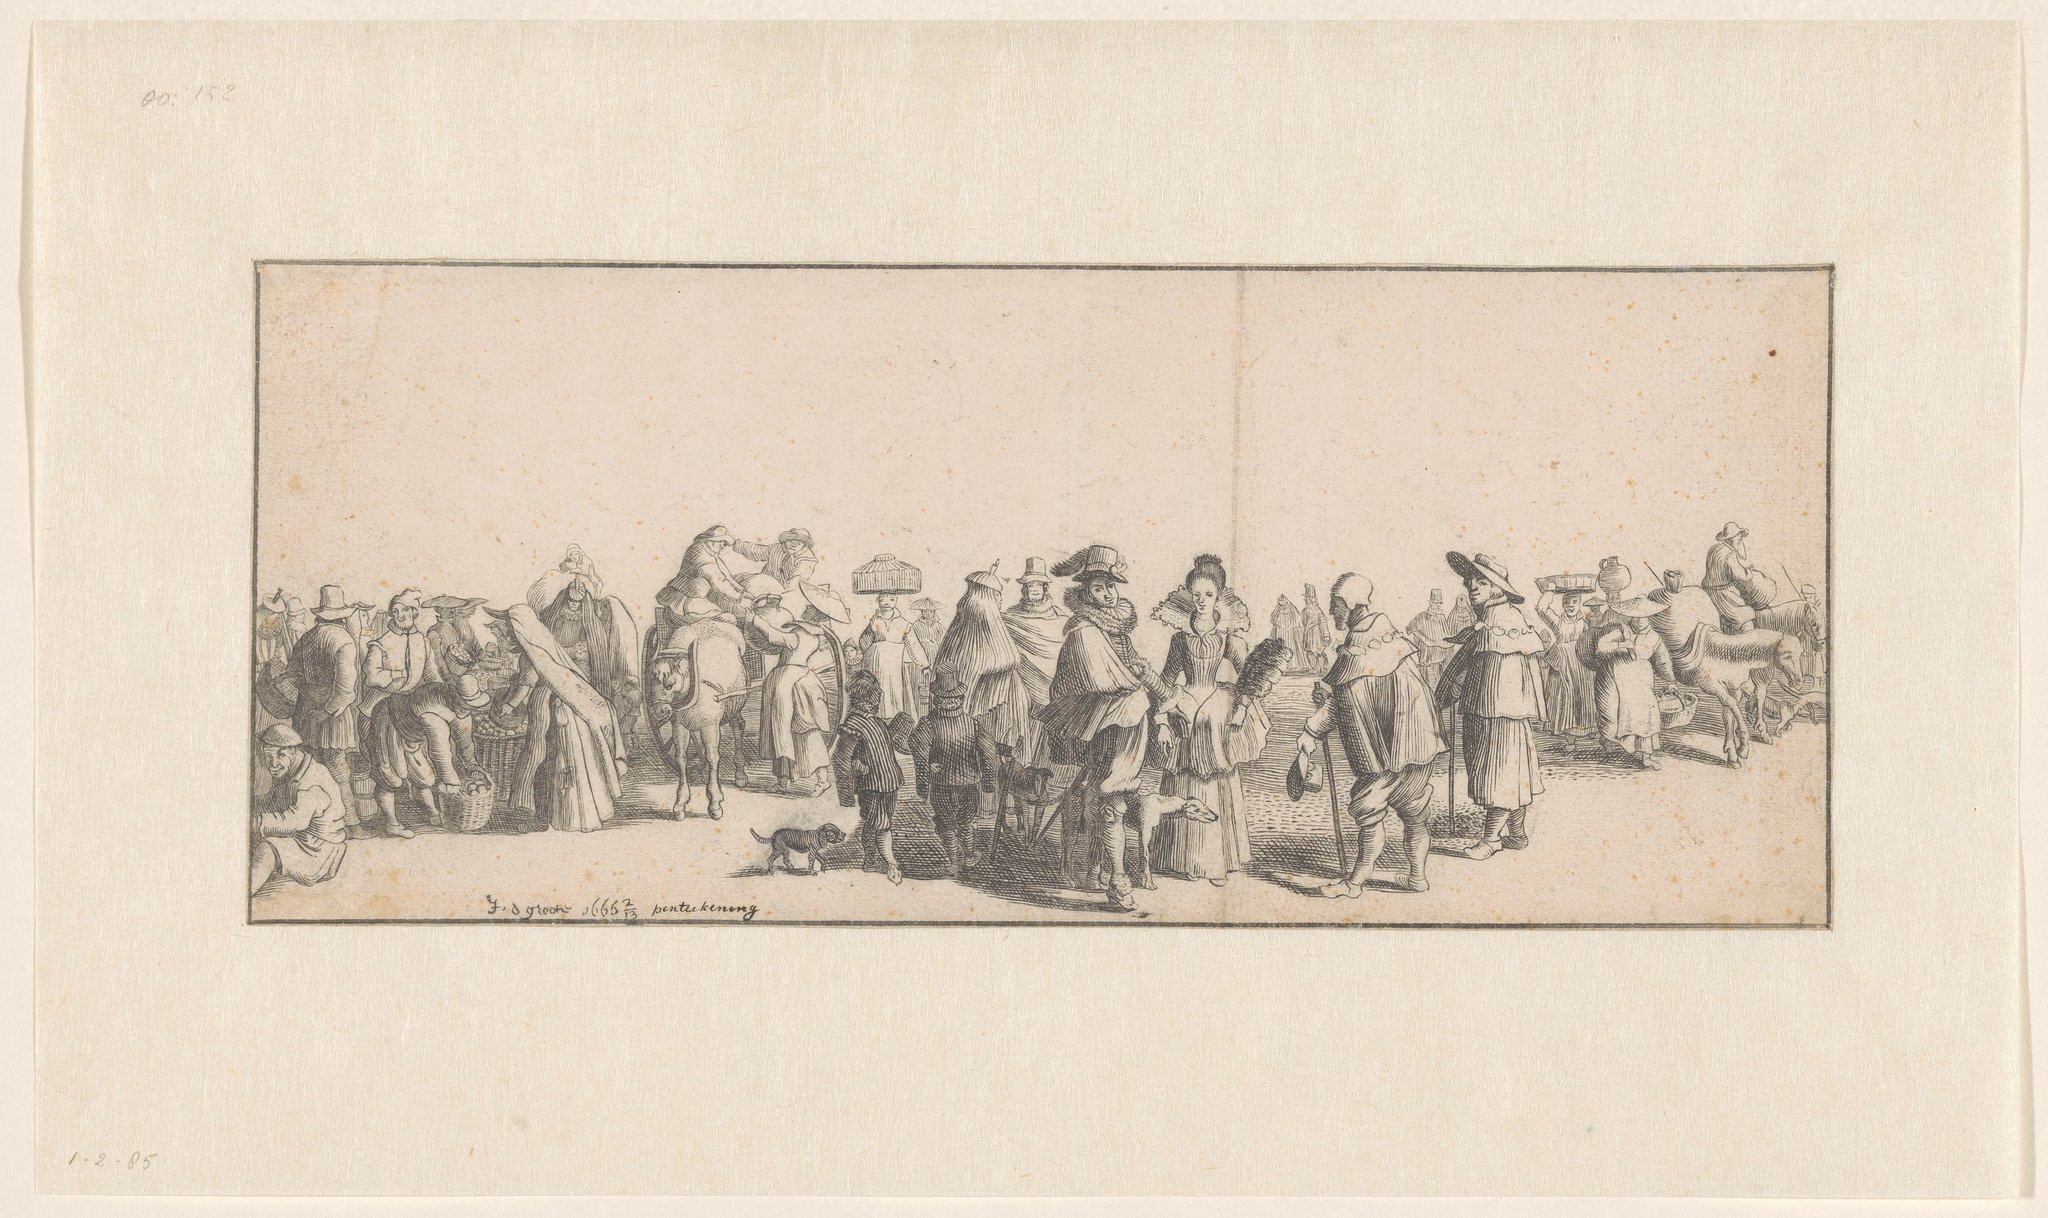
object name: drawing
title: Markttafereel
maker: johannes de groot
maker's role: draughtsman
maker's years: 1650-1726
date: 1666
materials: ink, paper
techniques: pen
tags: market